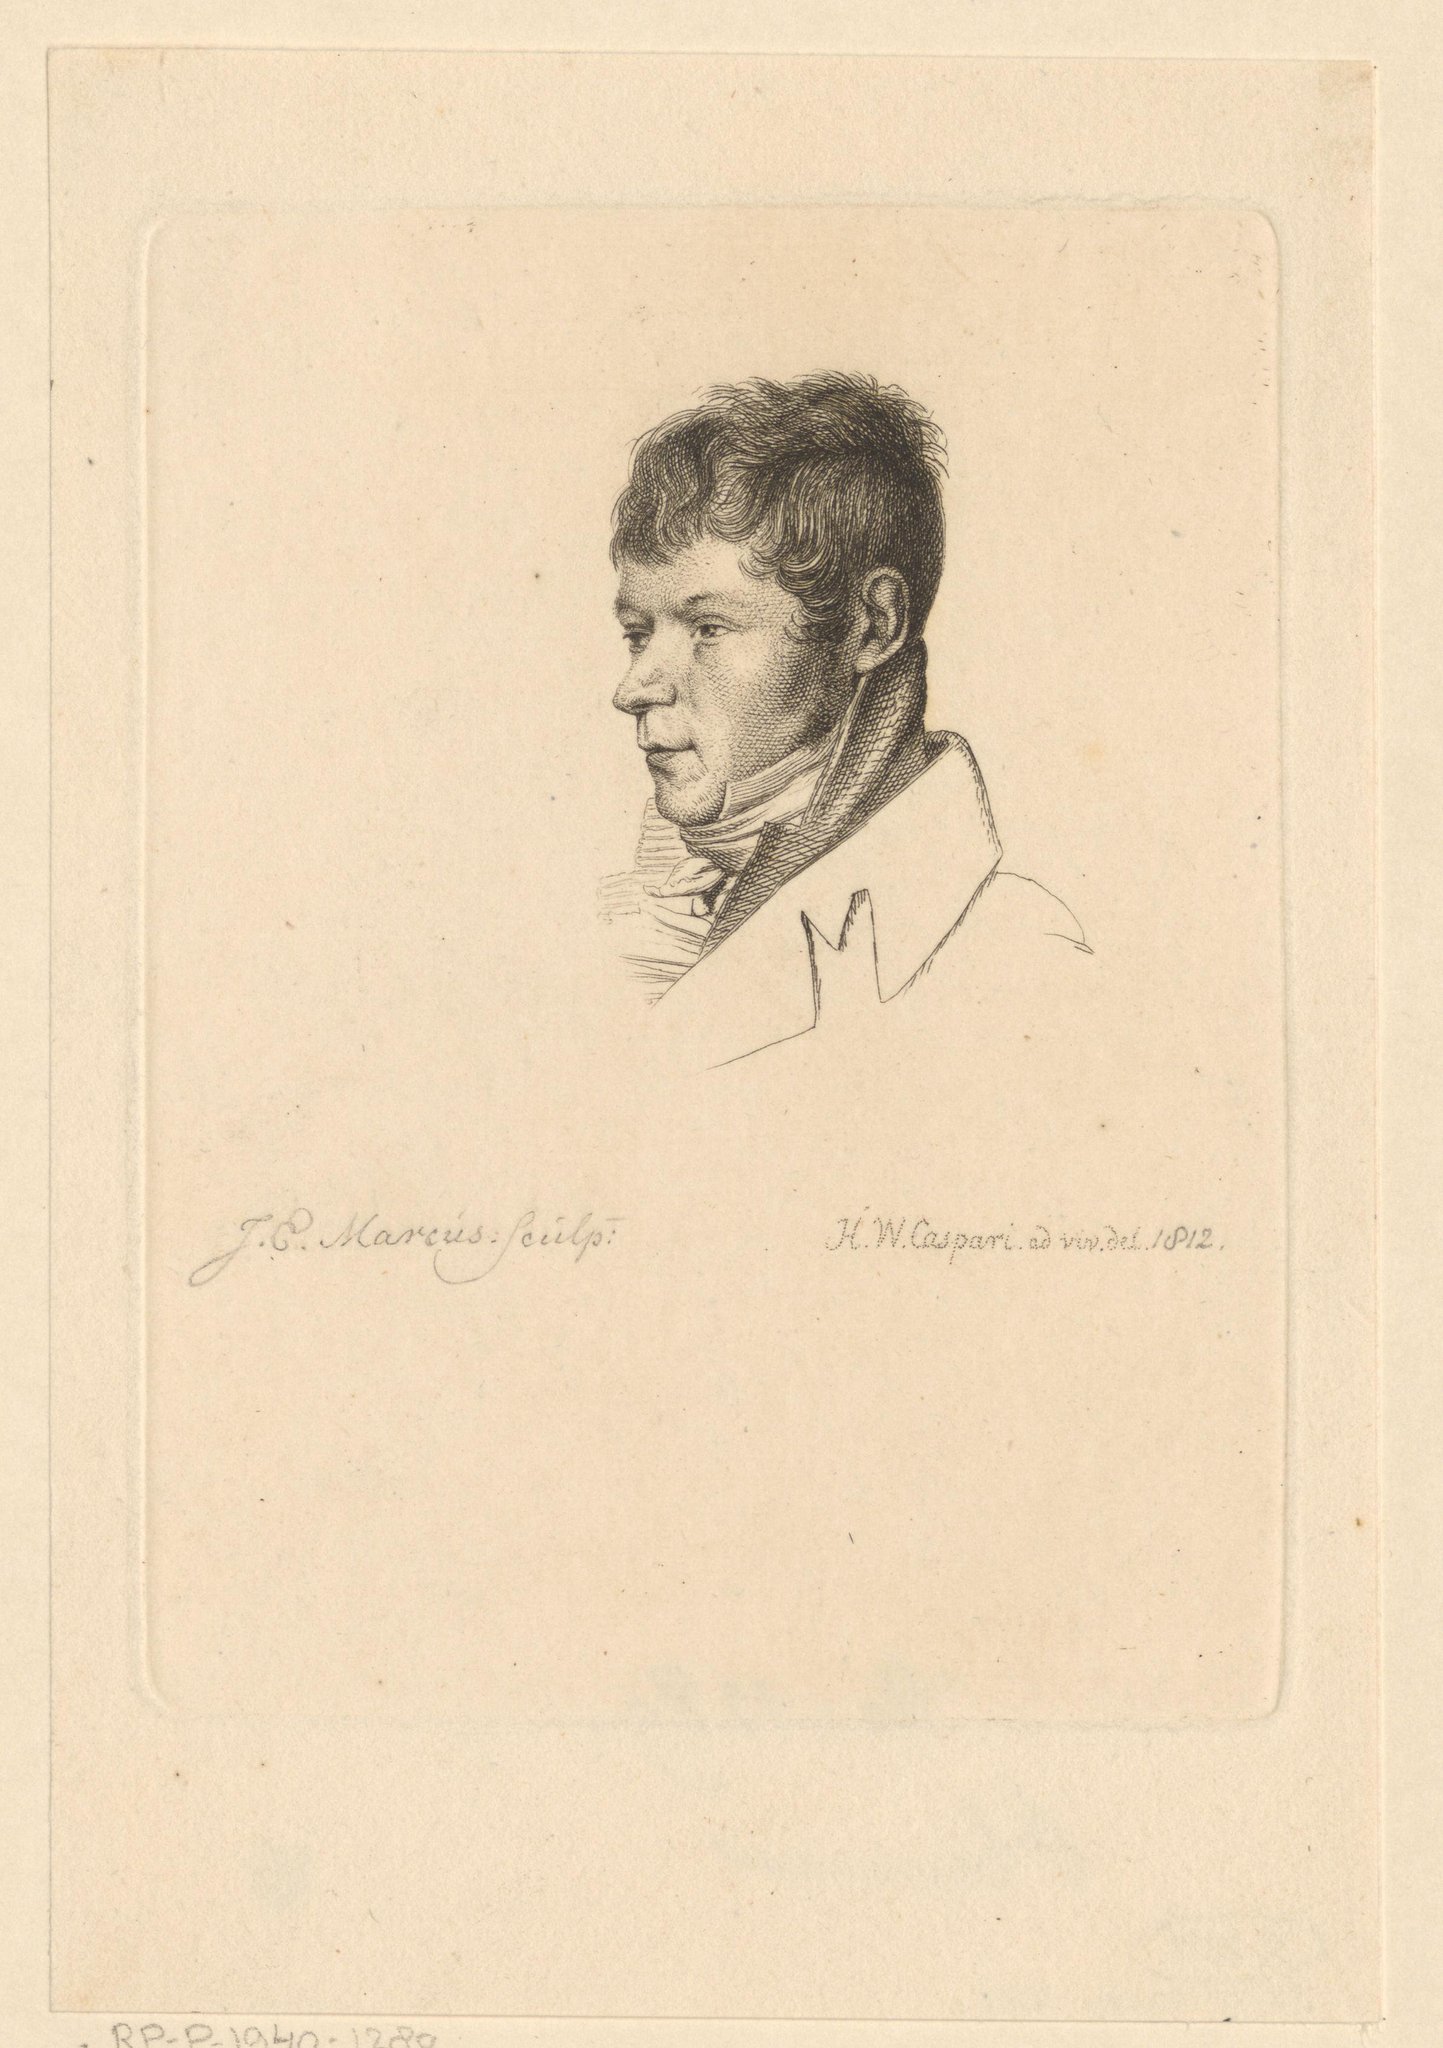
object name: print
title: Portret van Anthony Oberman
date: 1812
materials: paper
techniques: engraving, etching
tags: amsterdam, painter, print maker, draughtsman, anthony oberman, historical persons, portrait, self-portrait of painter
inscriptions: collector's mark: Lugt 2228, collector's mark: Lugt 2760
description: Latere staat van de gehele prent gebruikt in: Marcus, Jacob Ernst. Etudes gravées. Amsterdam: S. de Grebber, 1826.